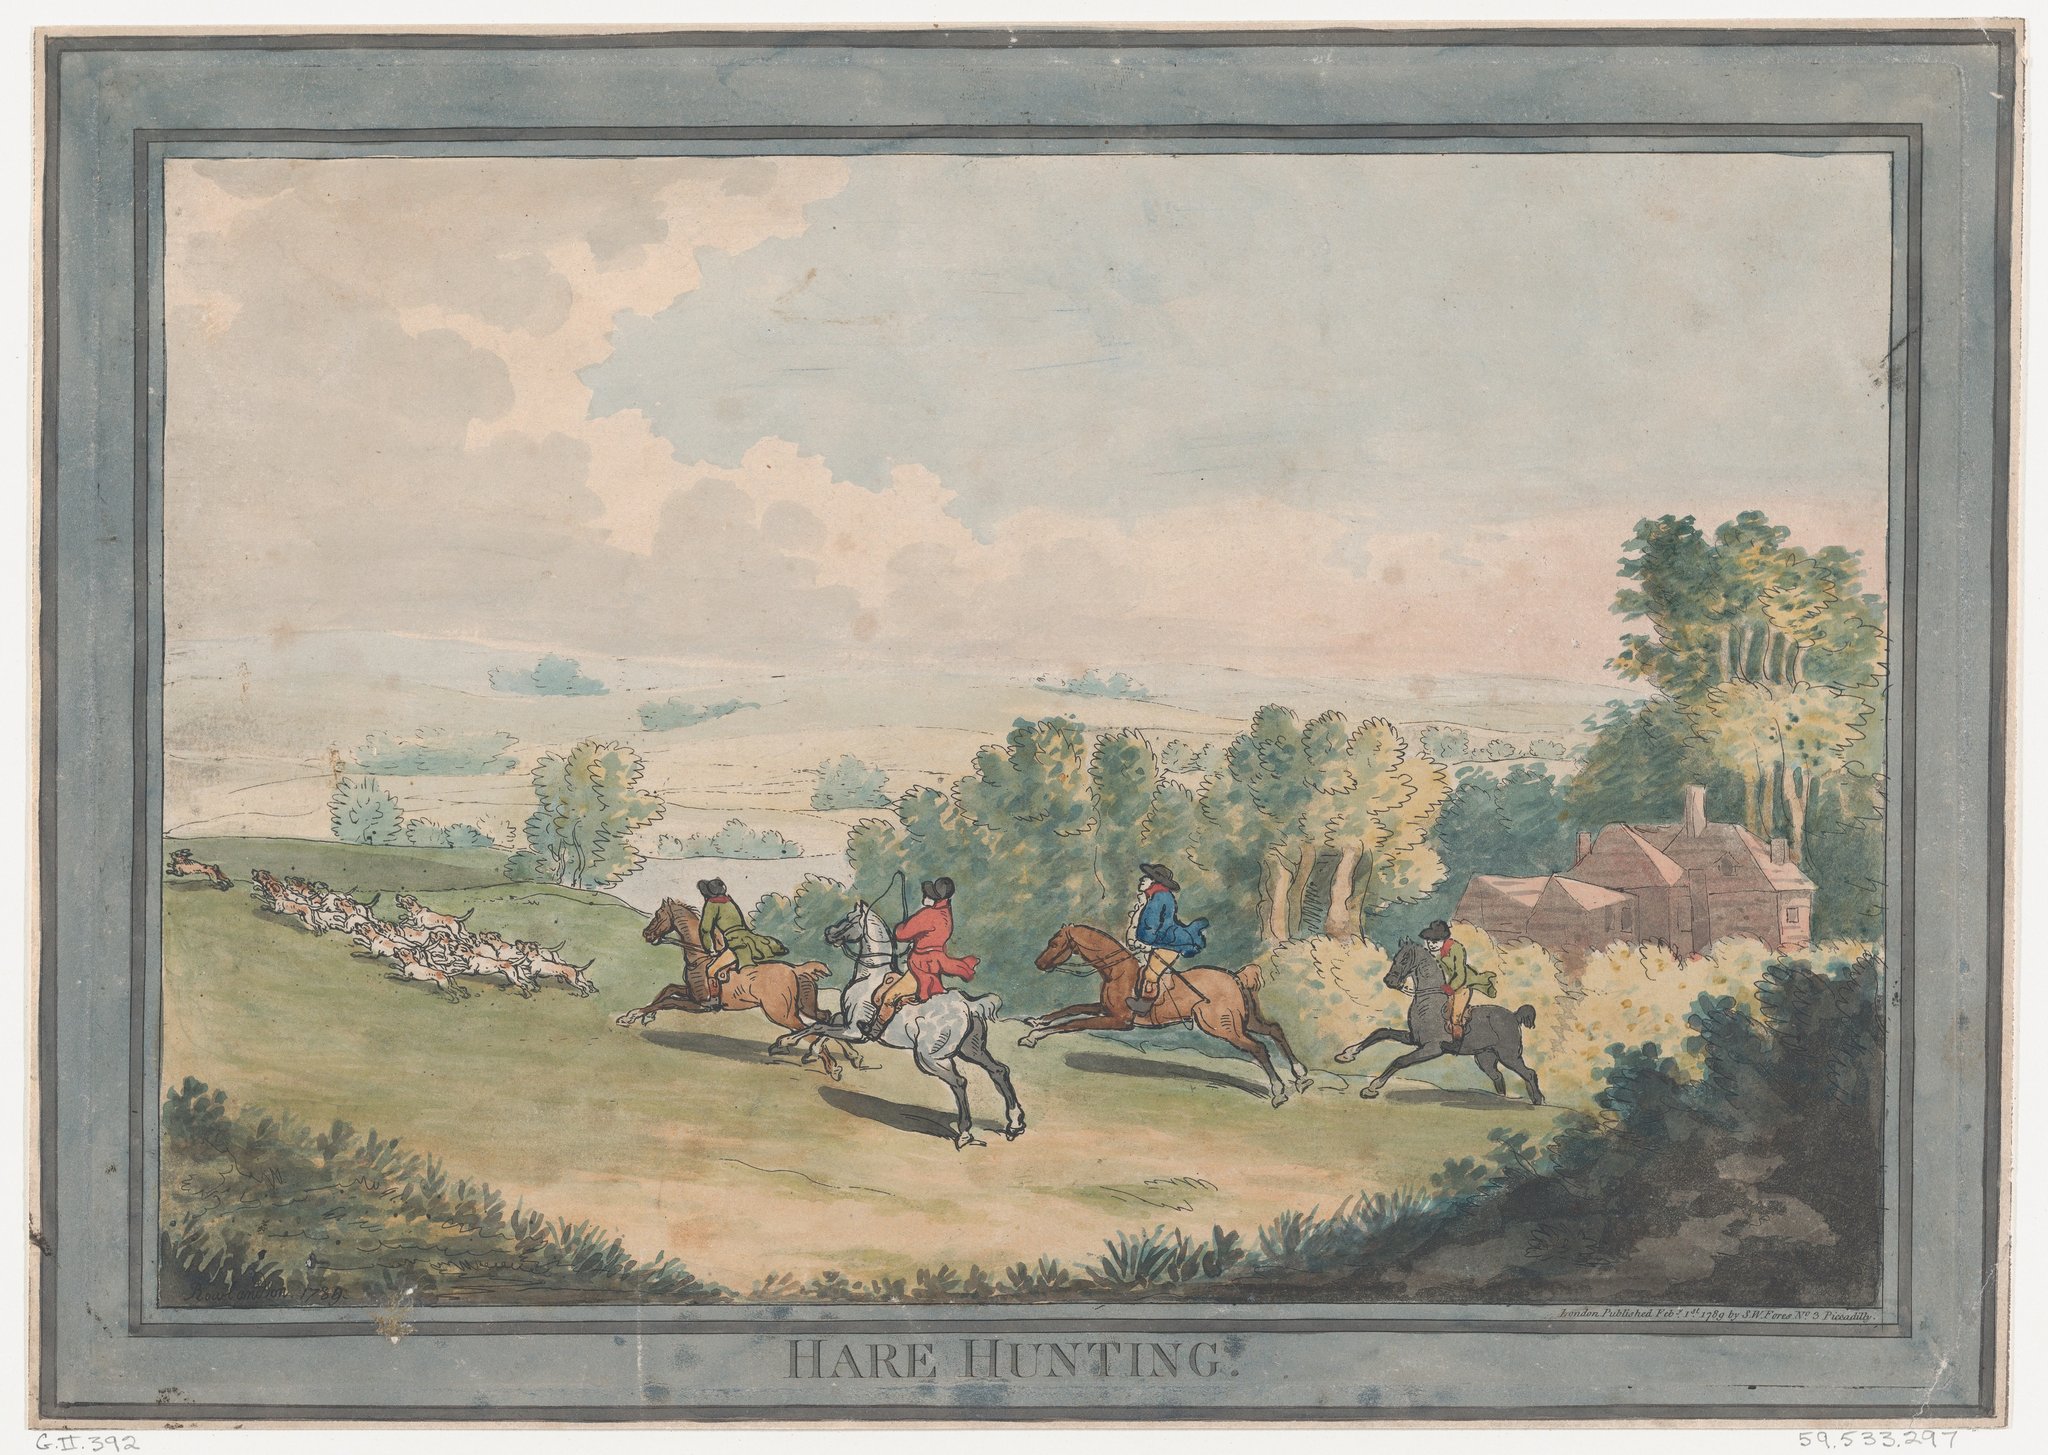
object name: print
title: Hare Hunting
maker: thomas rowlandson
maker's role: artist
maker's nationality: british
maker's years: 1757-1827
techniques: aquatint, etching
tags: human figures,hunting,horses,rabbits